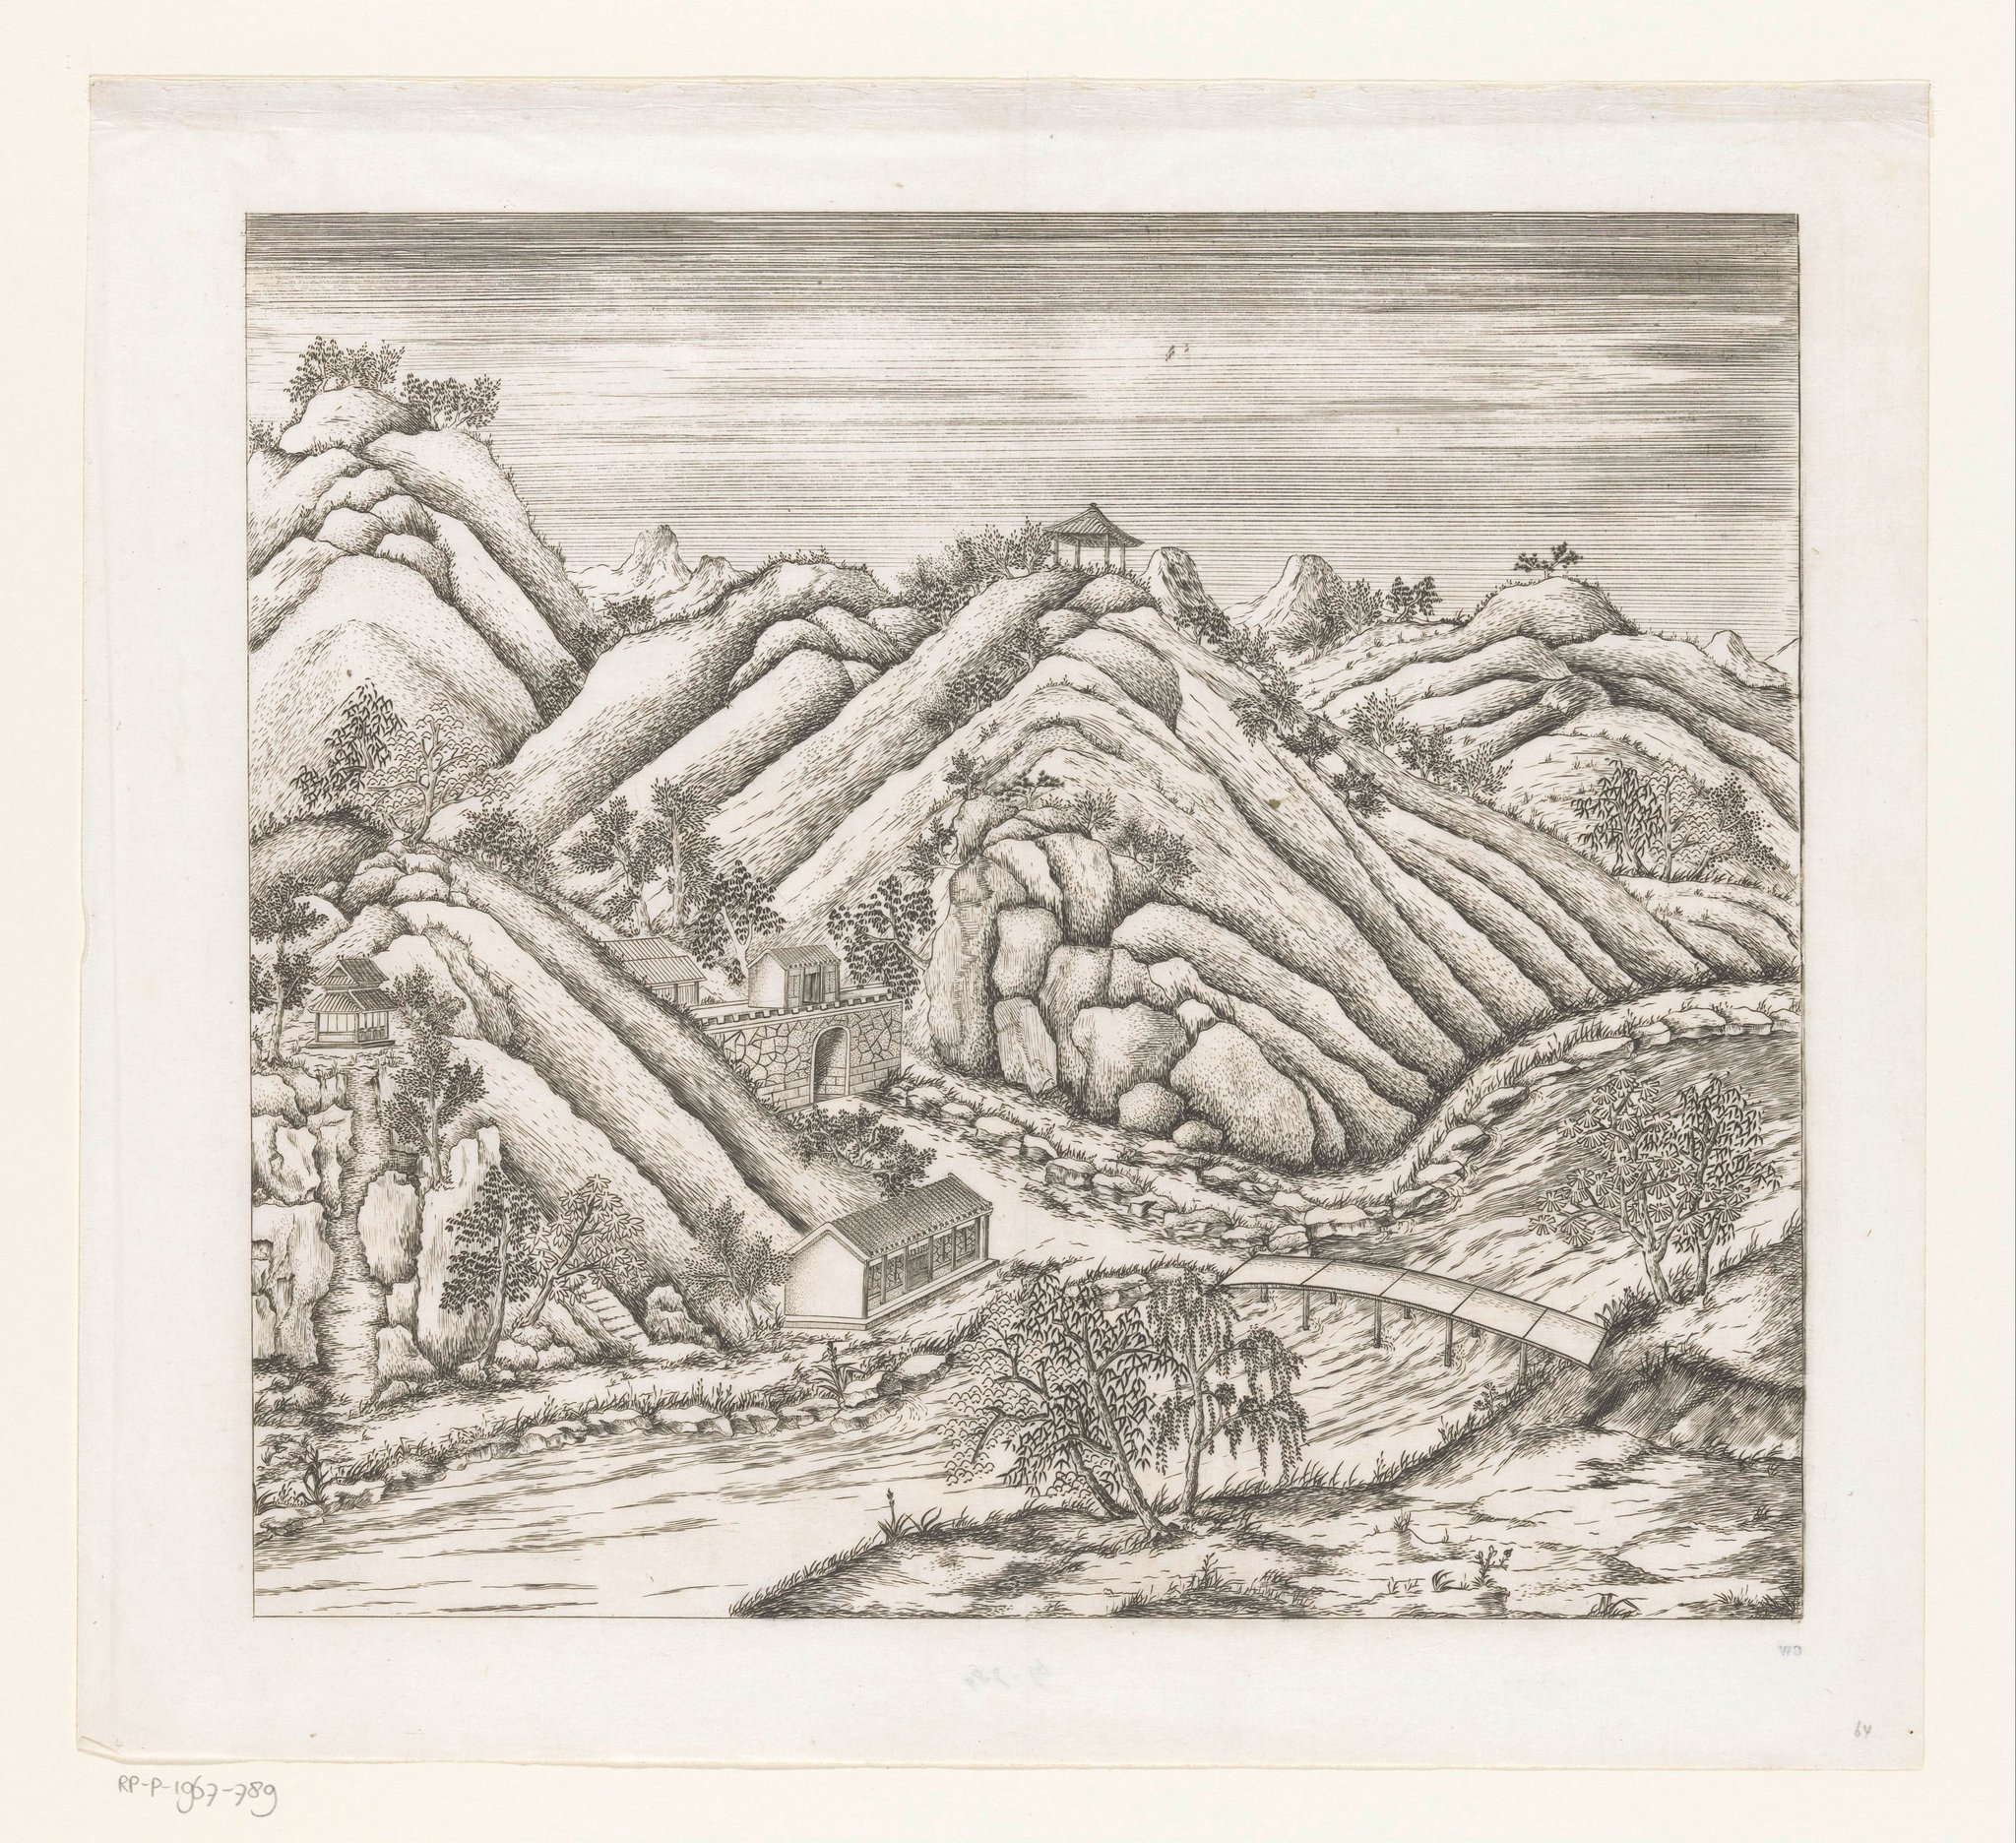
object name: print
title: ‘Shapes of Clouds and Figures in the Water’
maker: matteo ripa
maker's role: priest, print maker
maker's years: 1682-1746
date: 1712-1714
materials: paper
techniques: engraving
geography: china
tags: city-view, and landscape with man-made constructions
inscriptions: collector's mark: Lugt 2228, collector's mark: ‘GW’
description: This print illustrates Ripa’s struggle to render the Chinese landscape in a copperplate engraving. He mimicked the shape of the mountains depicted in the woodcut: however, he did not entirely fill in their surface with lines, instead using sparse hatching to create shading and give them volume. The foliage of the trees, on the other hand, does adhere to the Chinese style in the woodcut.